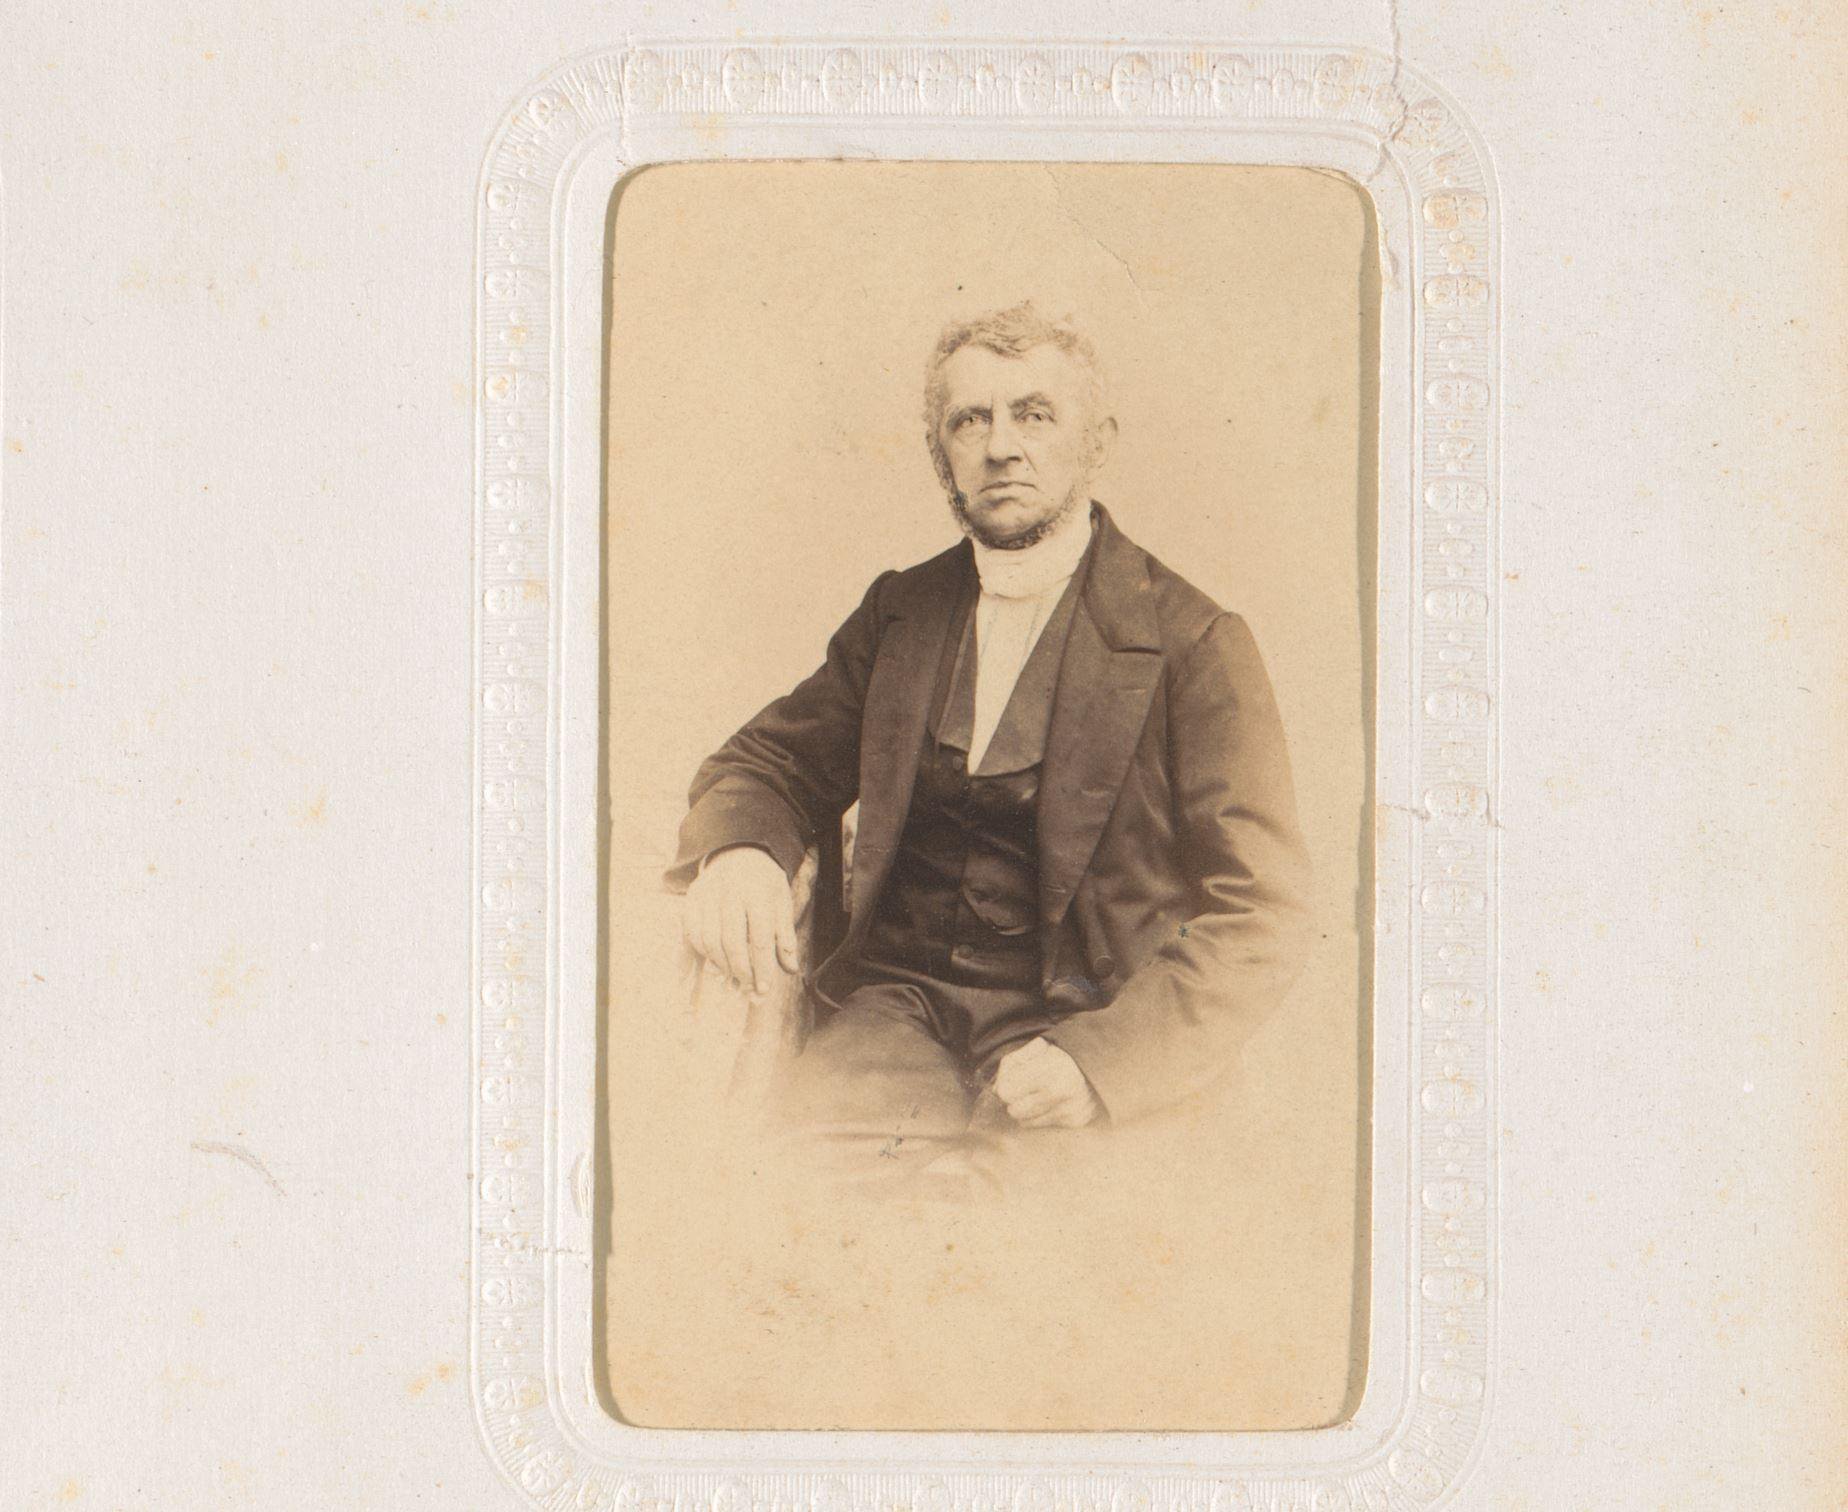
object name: carte de visite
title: Portret van een zittende oude man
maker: Anonymous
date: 1850-1880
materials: cardboard, photographic support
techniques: albumen print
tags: historical persons, old man